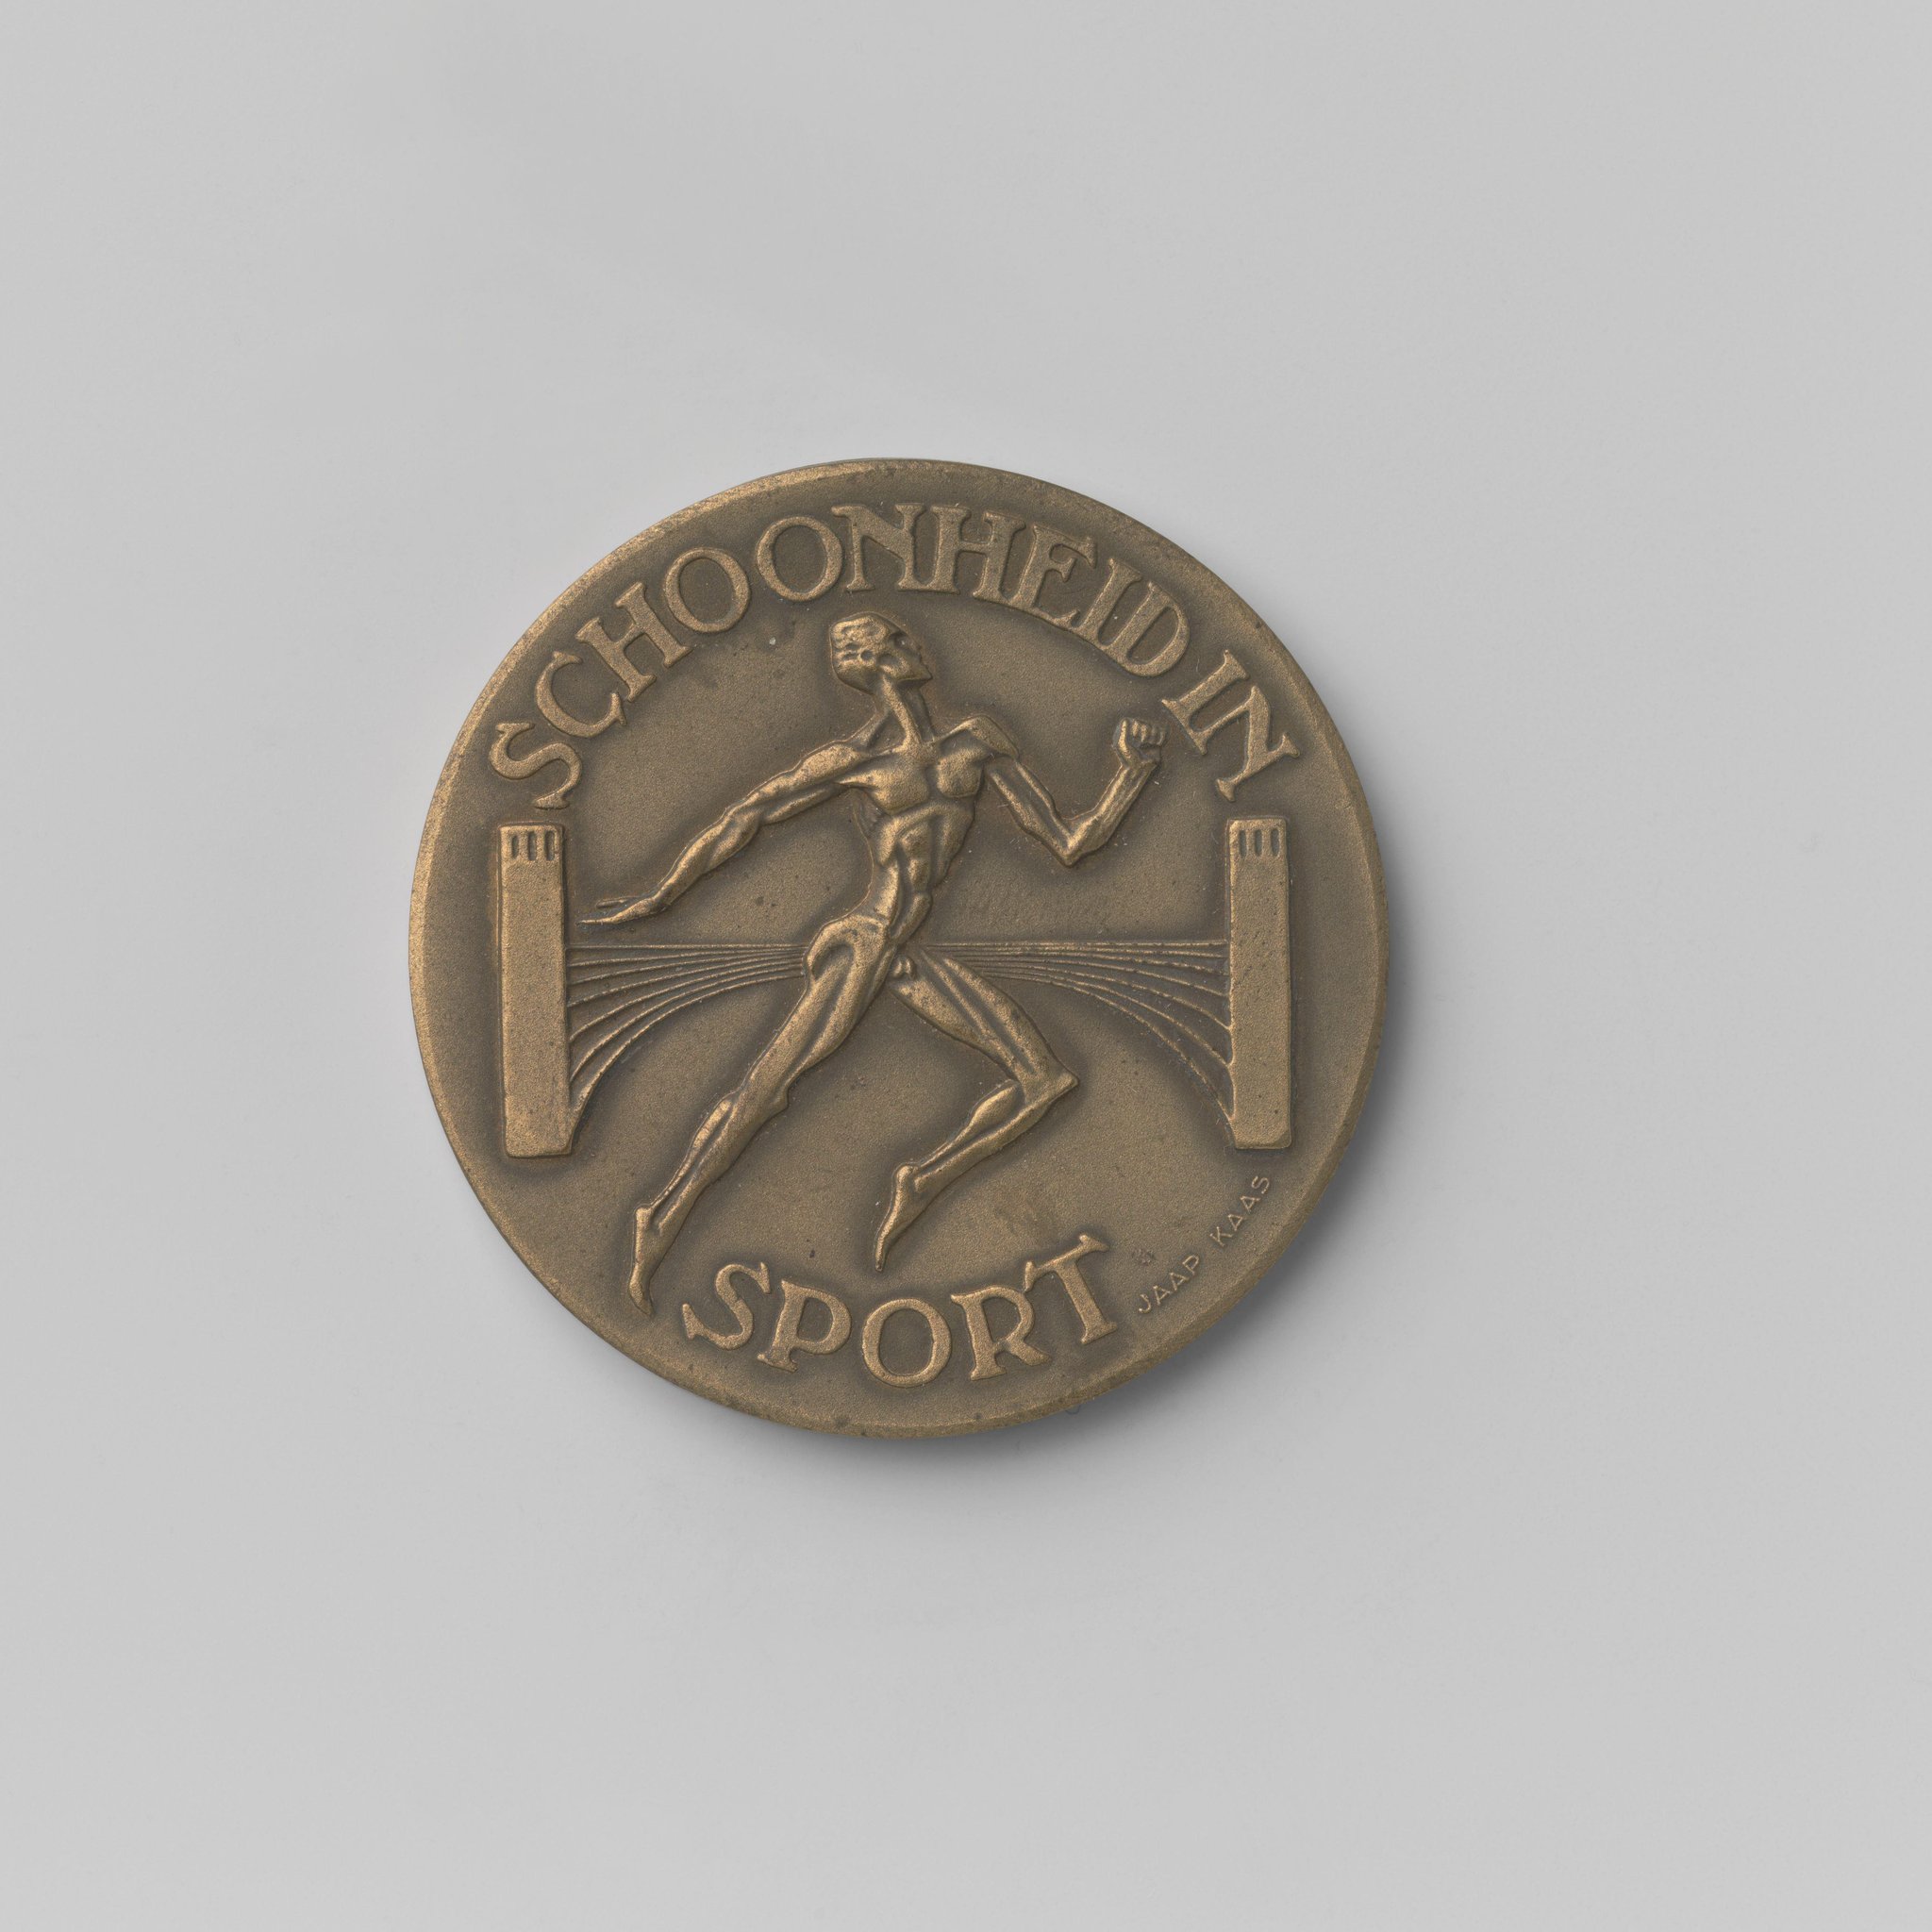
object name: history medal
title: Schoonheid in Sport, Olympische Spelen te Amsterdam (Vereniging voor Penningkunst 1927, tweede penning)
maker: jaap kaas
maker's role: draughtsman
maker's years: 1898-1972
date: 1928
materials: bronze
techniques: striking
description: Bronzen penning, op de voorzijde een hardloper bij het eindlint, met omschrift, op de keerzijde een PK-monogram tussen 19 en 28, met verklaring.